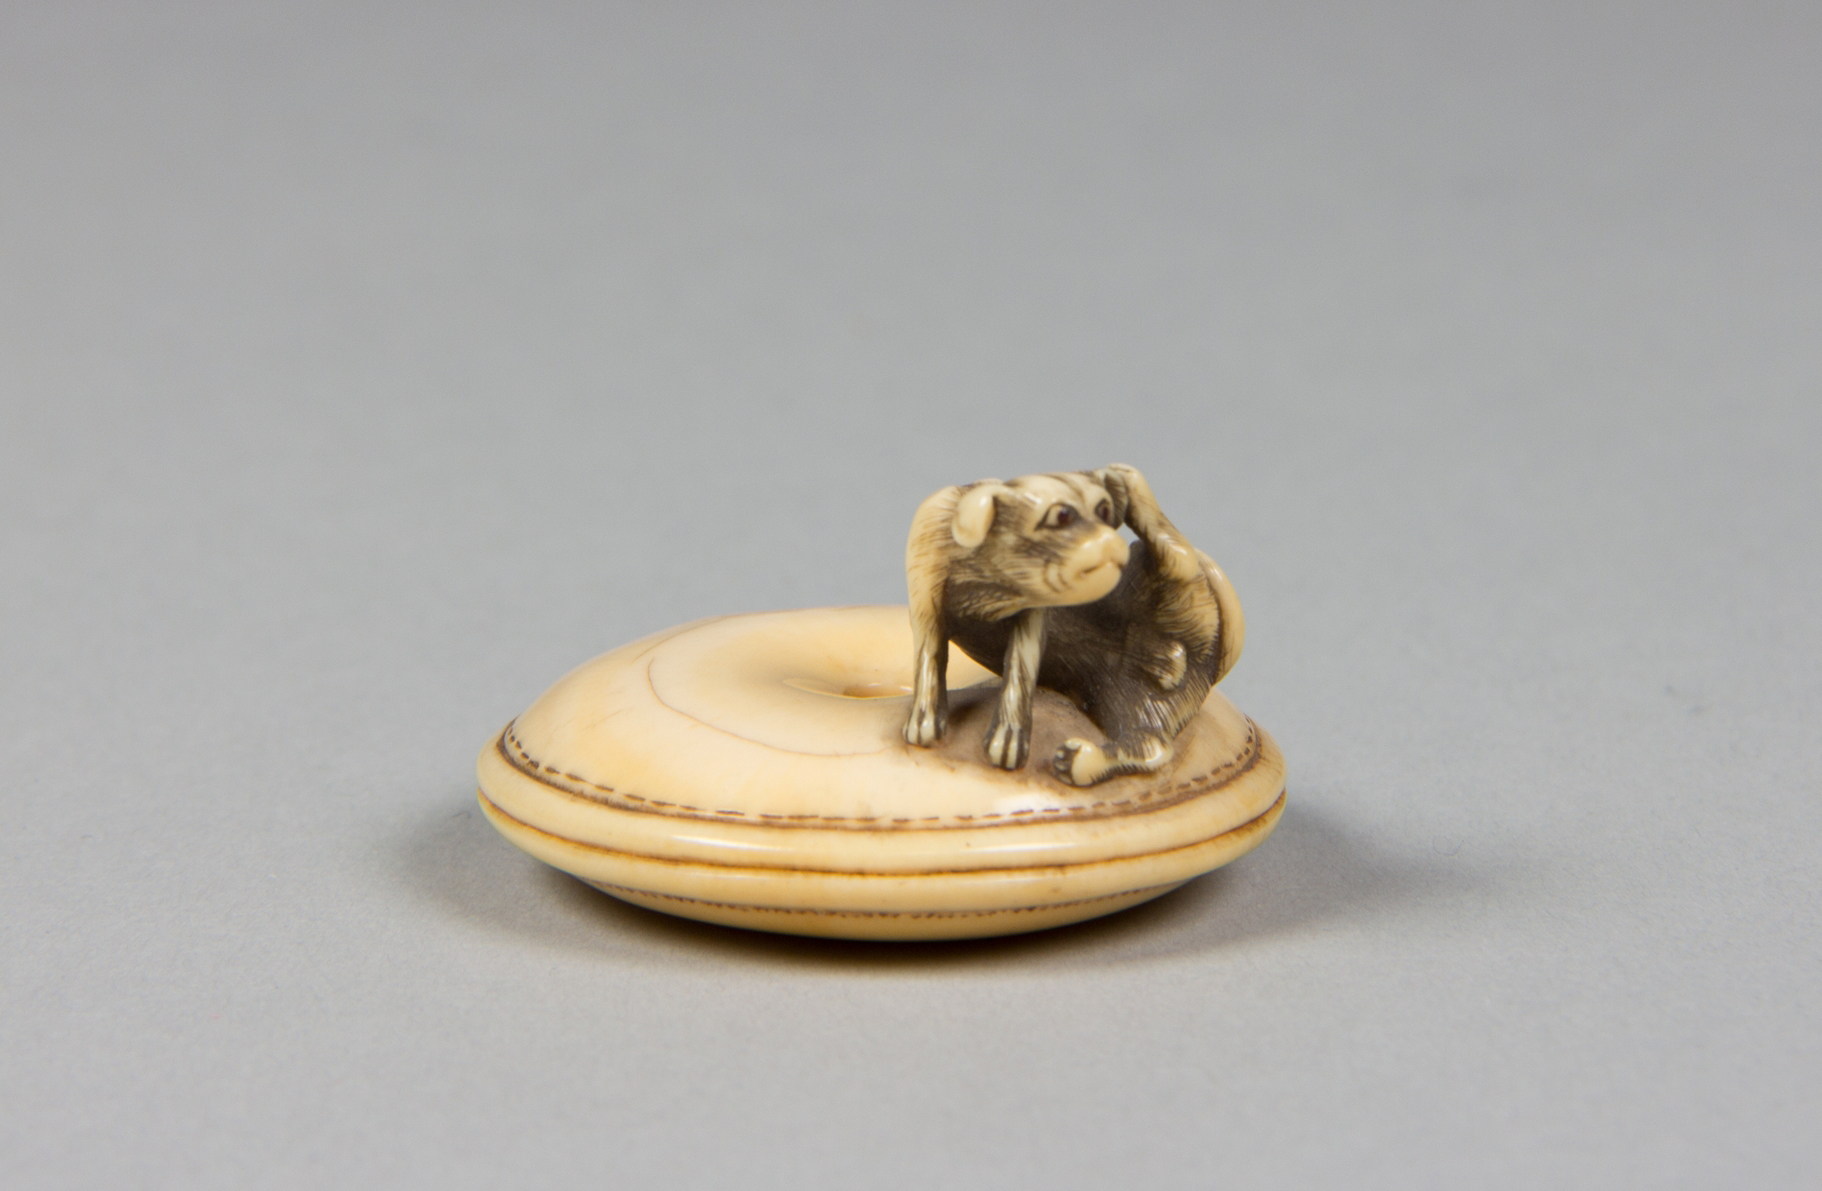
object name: netsuke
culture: japanese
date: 1701-1800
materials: ivory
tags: dogs